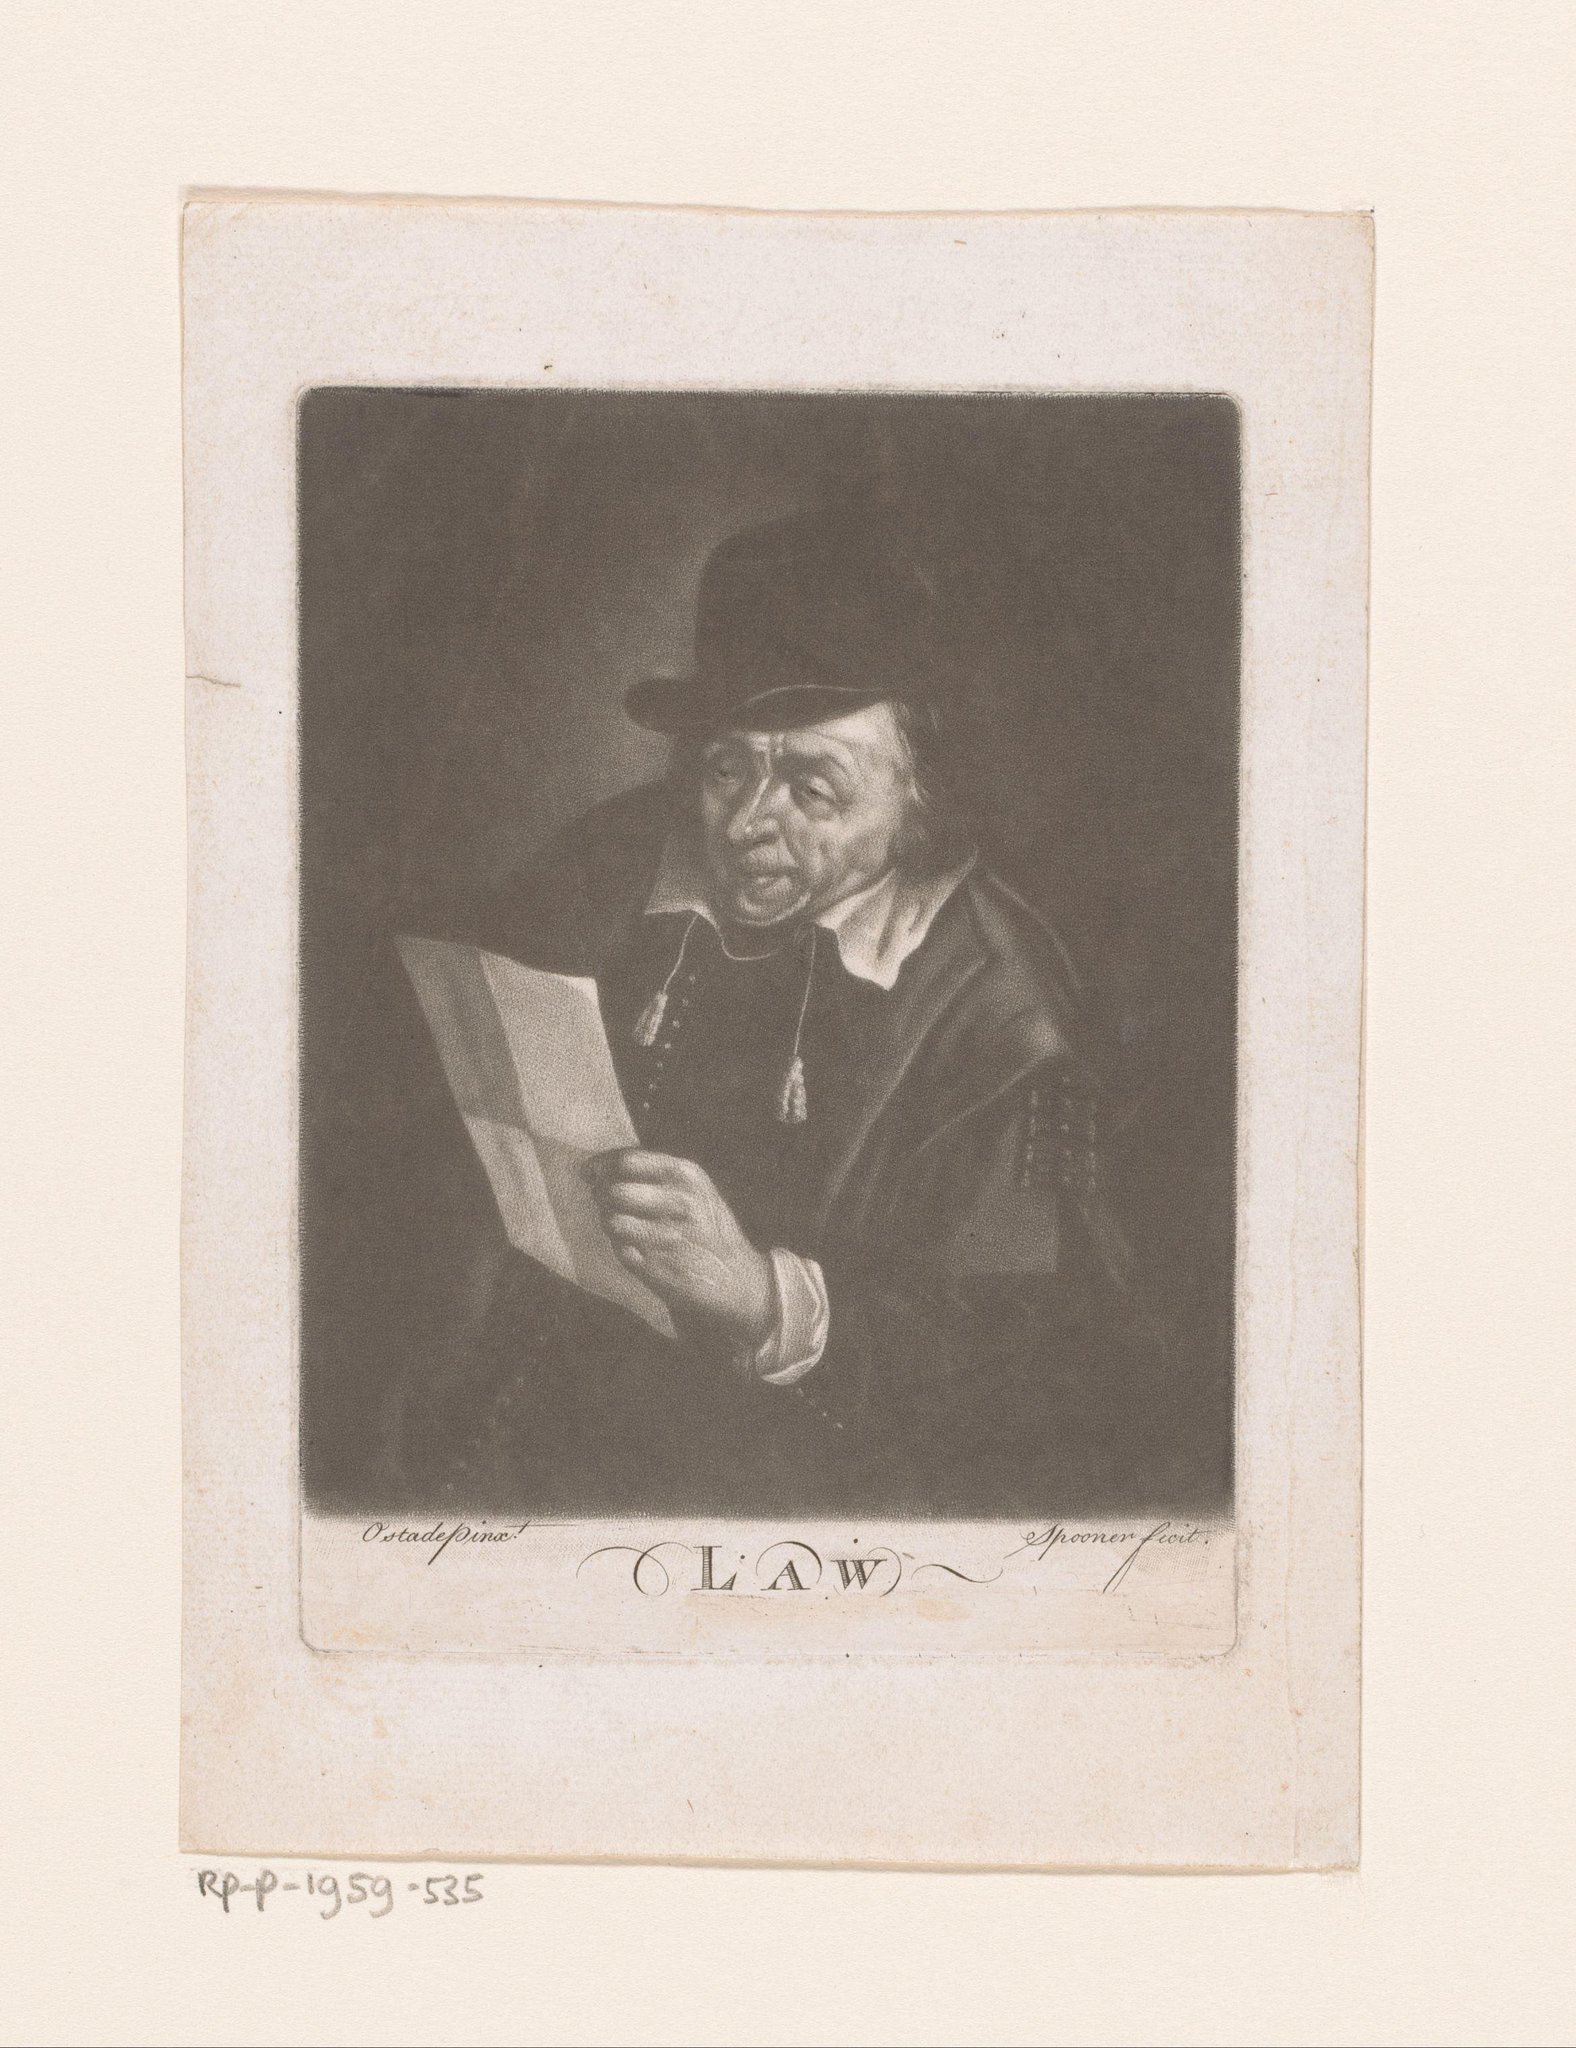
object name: print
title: Brieflezer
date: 1745-1767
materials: paper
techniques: mezzotint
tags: reading, letter, envelope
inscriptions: collector's mark: Lugt 2228